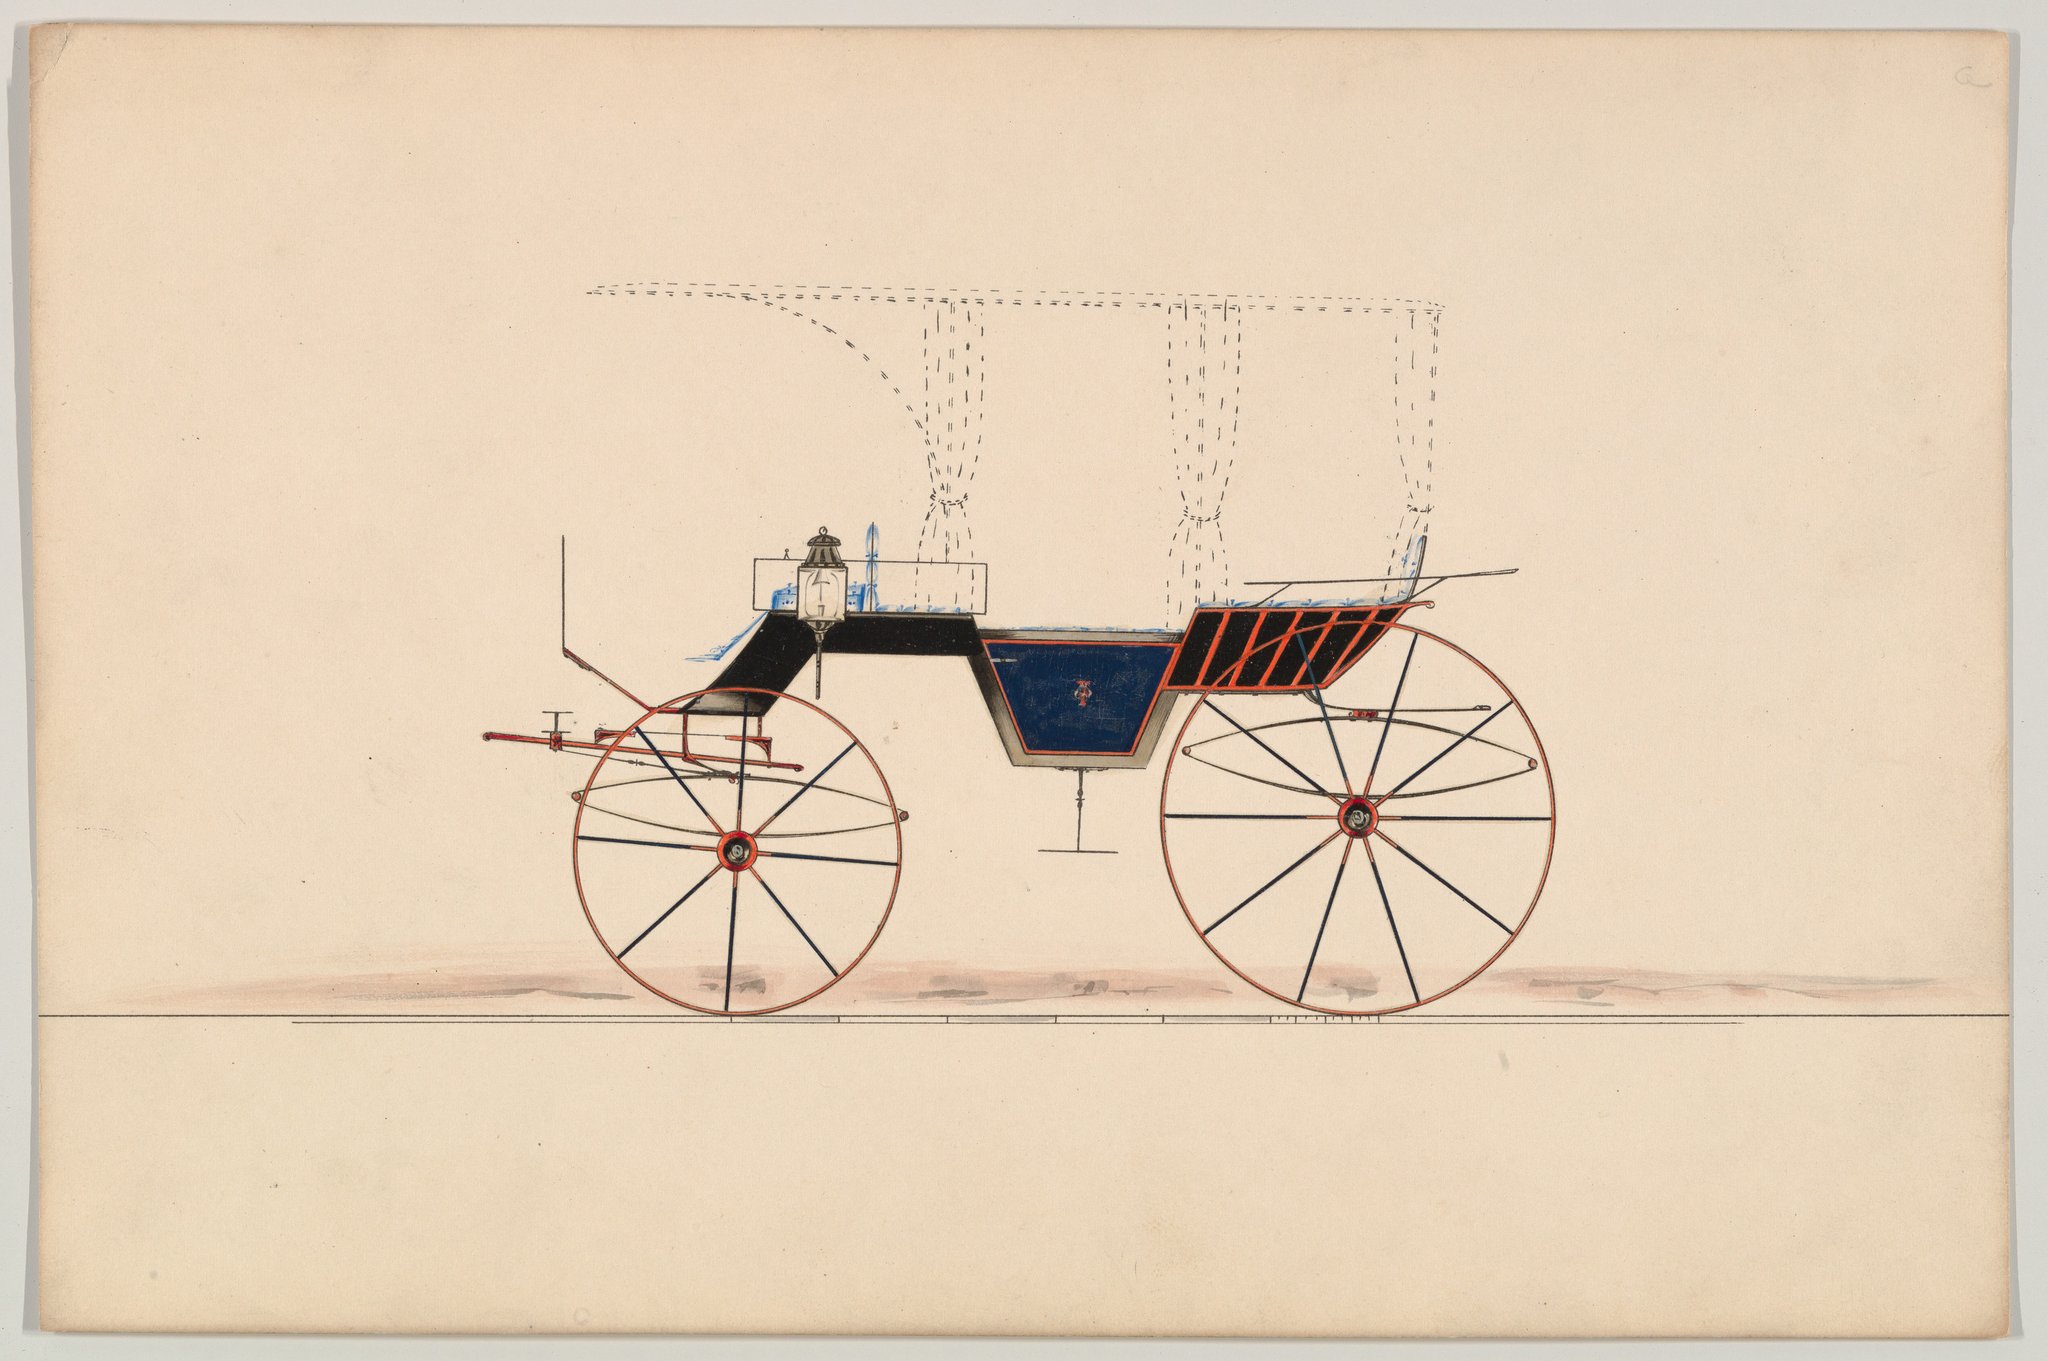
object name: drawing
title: Design for Vis-à-vis (unnumbered)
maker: brewster & co.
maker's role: manufacturer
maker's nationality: american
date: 1850-1870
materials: gouache, gum arabic, ink, watercolor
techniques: pen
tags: carriages